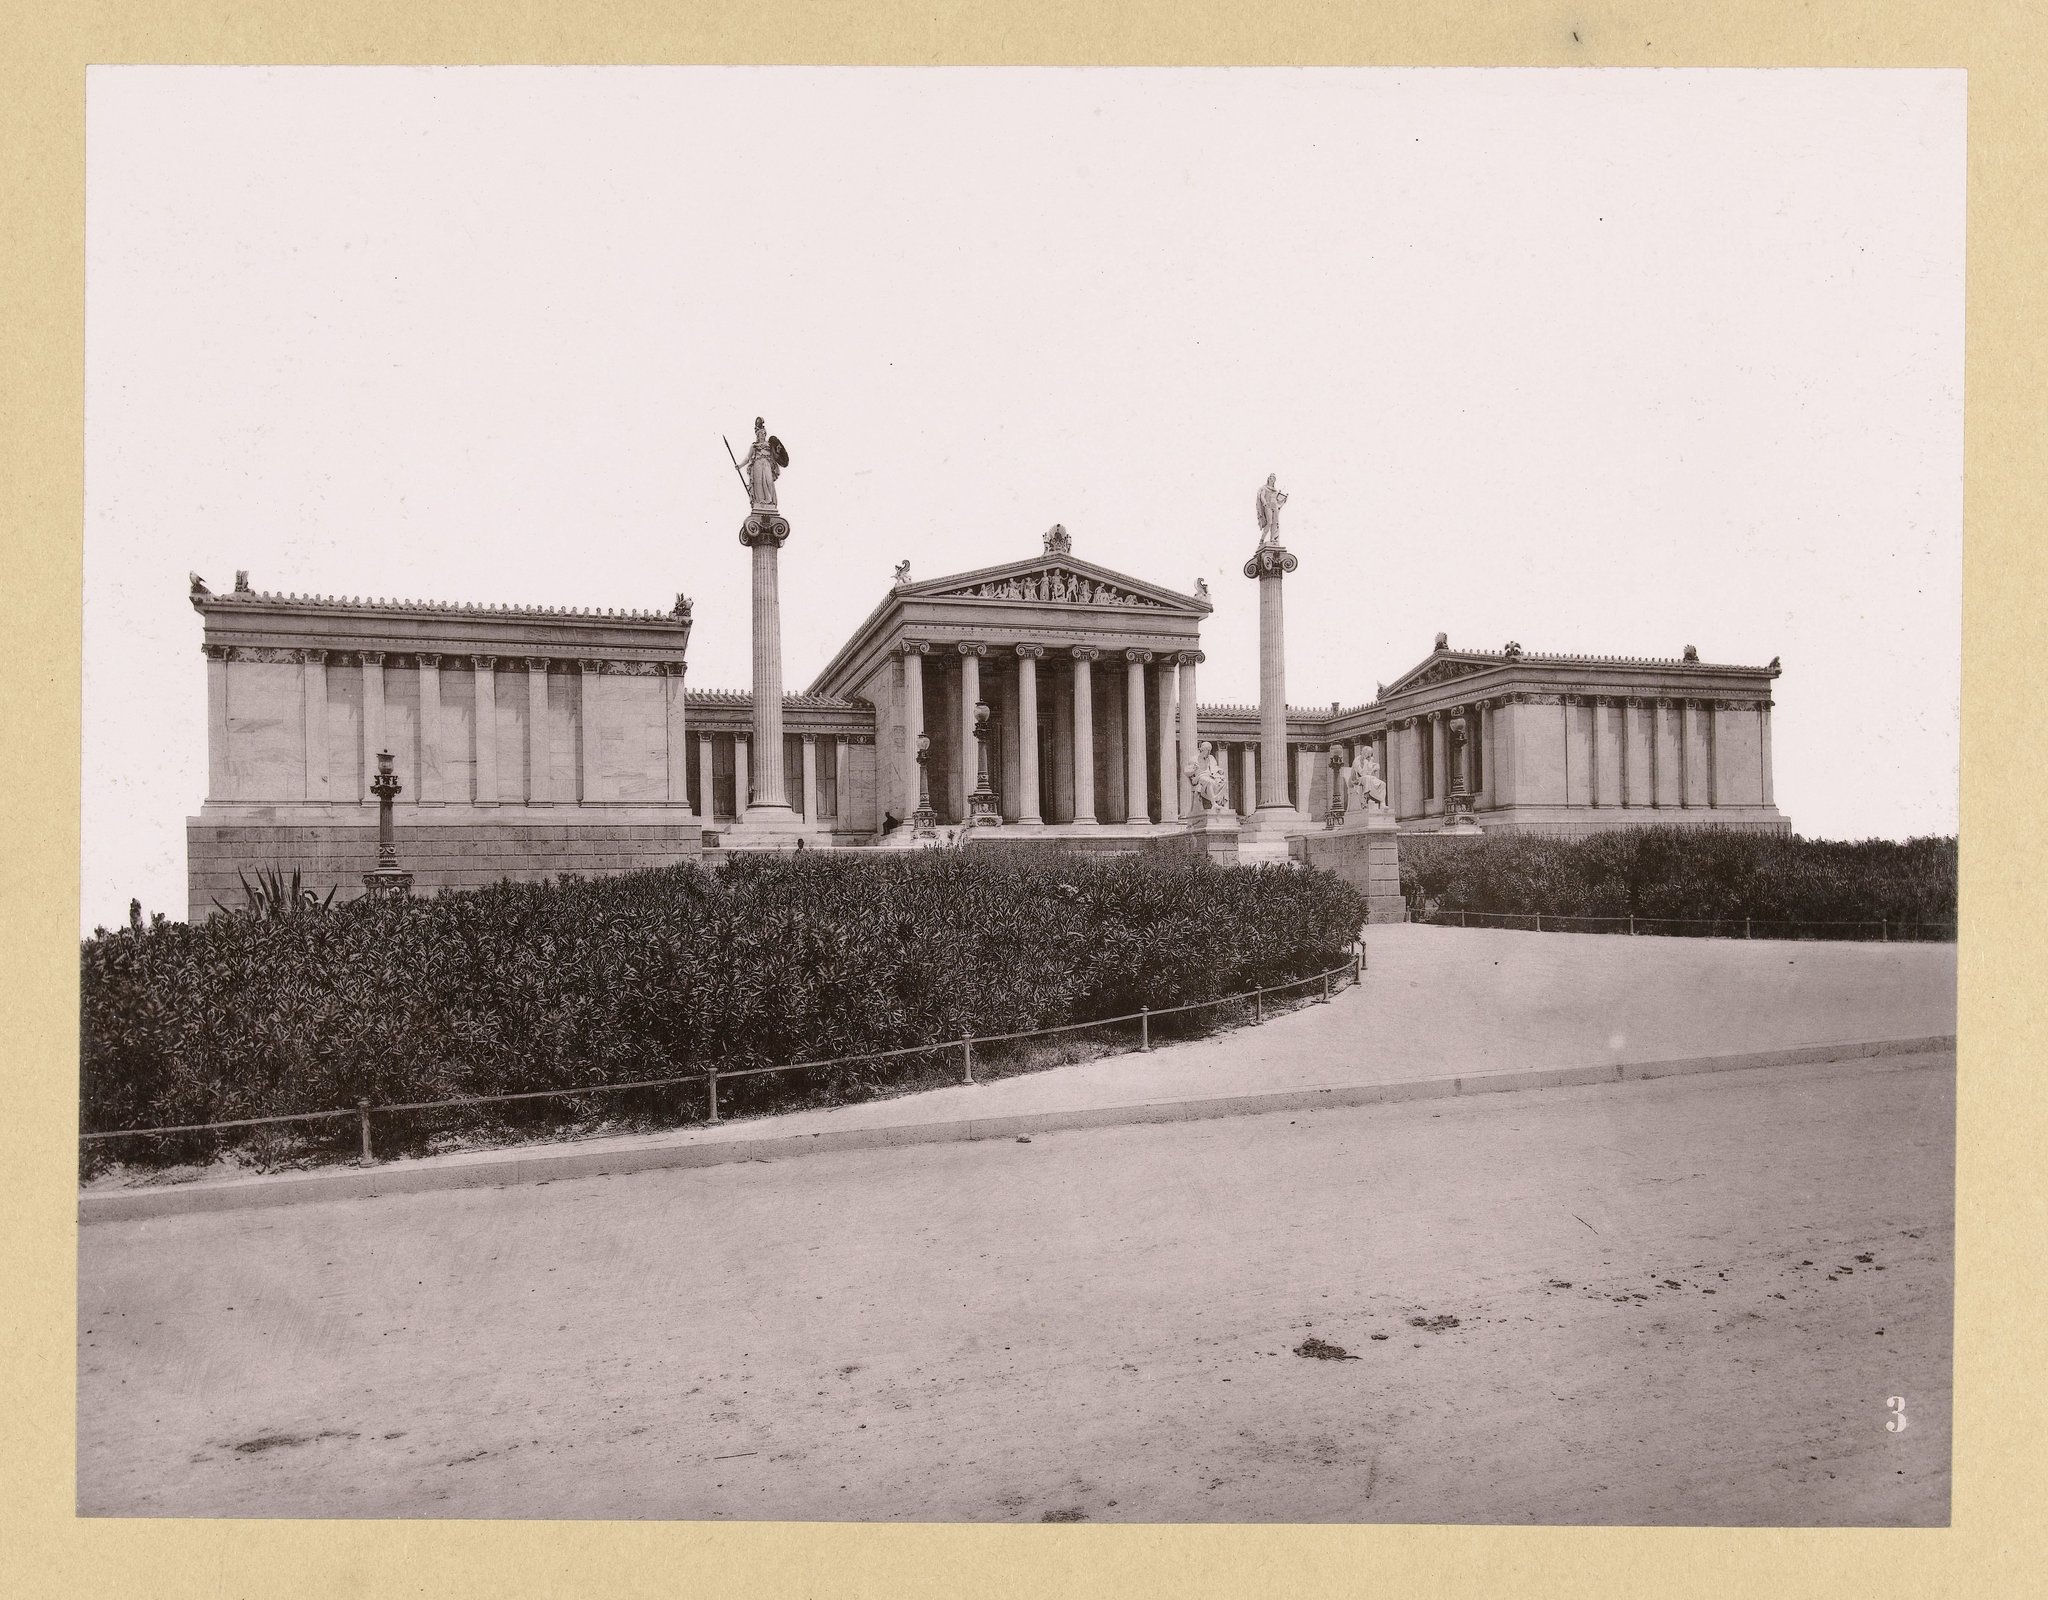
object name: photomechanical print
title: G 31. De Universiteit. Athene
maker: Anonymous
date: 1890-1893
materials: cardboard, paper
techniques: photograph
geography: athens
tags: university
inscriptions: check stamp: ‘Bristol/ L.M.’, title: ‘G 31. De Universiteit. Athene.’, number: ‘3’, stamp: ‘Gemeentelijke bibliotheek/ Rotterdam’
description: Onderdeel van een groep door fotograaf Richard Polak op reis verzamelde foto’s. Deze fotomechanische afdruk is samen met andere op zijn reizen verzamelde foto's tentoongesteld bij de Rotterdamsche Kunstkring (1895), Arti en Amicitiae te Amsterdam (1897-1898?) en Societeit 't Collegie te Kampen (datum vooralsnog onbekend).